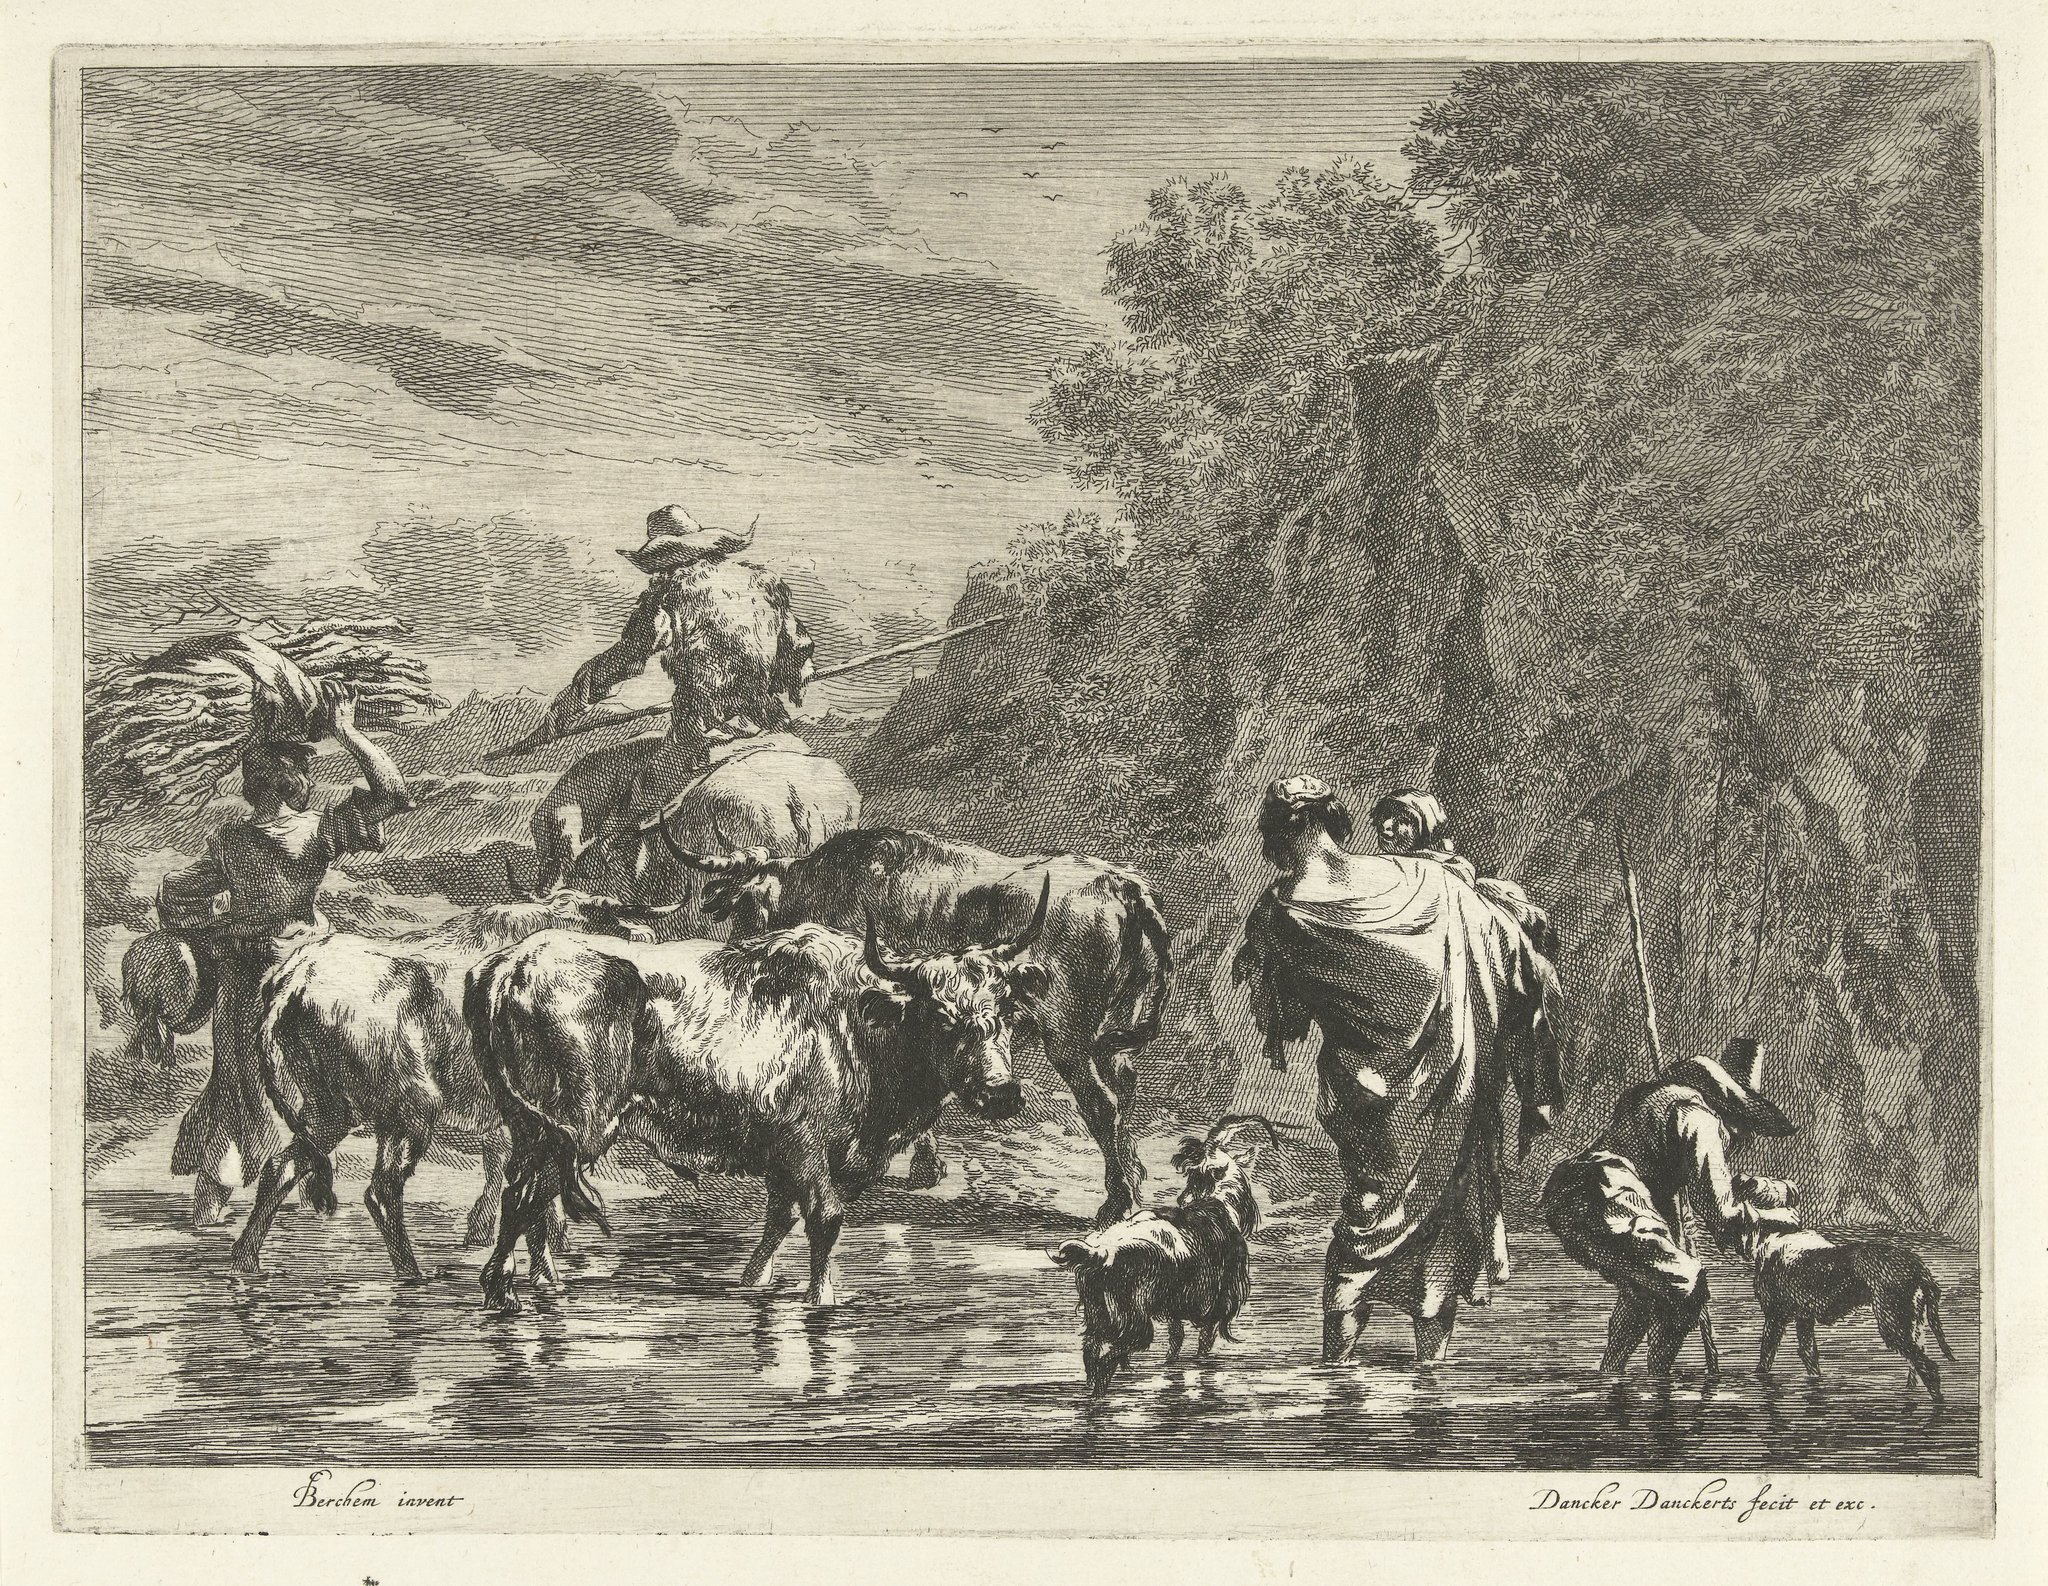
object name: print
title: Zuidelijke landschappen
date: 1643-1666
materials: paper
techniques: etching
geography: amsterdam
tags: crossing a river, herding, herdsman, herdswoman, shepherd, shepherdess, cowherd, etc., rocks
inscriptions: collector's mark: Lugt 240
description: Prent uit serie van zes landschappen naar ontwerp van Nicolaes Pietersz. Berchem.